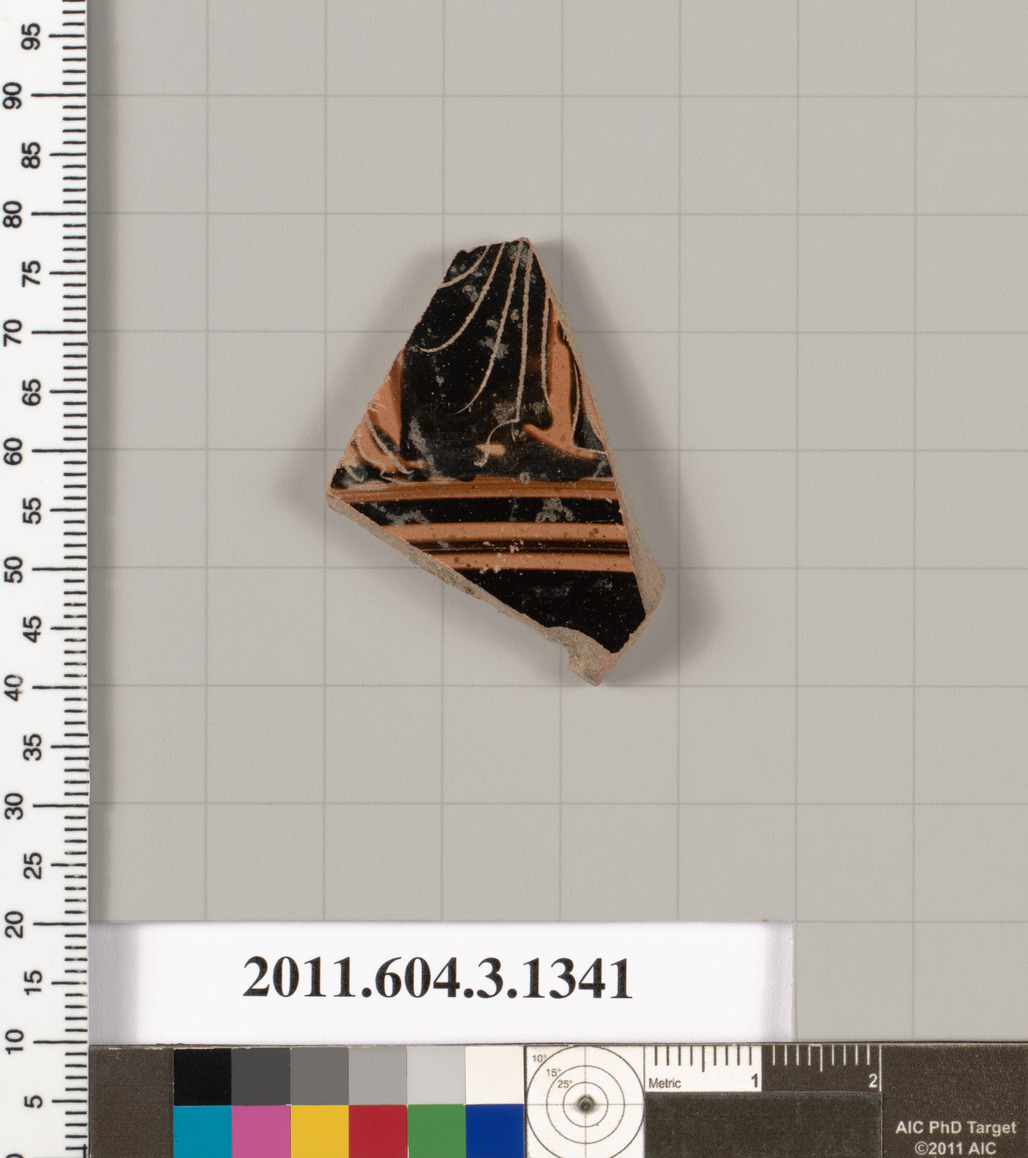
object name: skyphos fragment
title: Terracotta fragment of a skyphos (deep drinking cup)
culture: greek, attic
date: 500-468 BCE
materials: terracotta